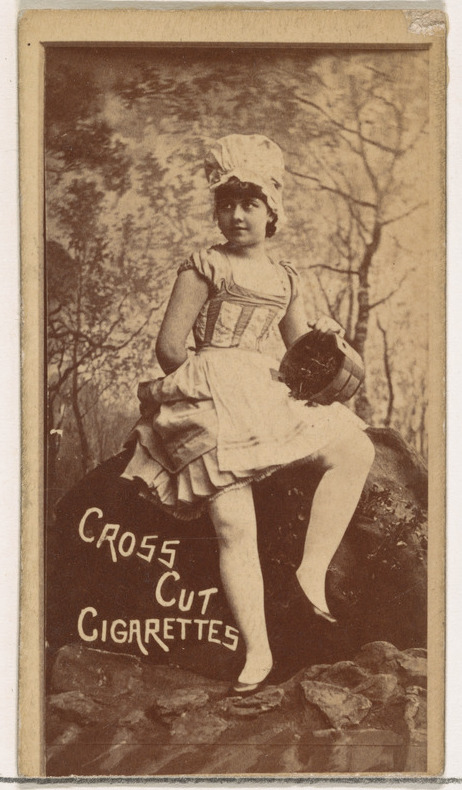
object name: print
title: Actress holding bucket, from the Actors and Actresses series (N145-1) issued by Duke Sons & Co. to promote Cross Cut Cigarettes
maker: w. duke, sons & co.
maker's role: publisher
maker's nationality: american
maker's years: 1870-1920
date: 1880-1889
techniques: albumen silver print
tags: portraits,women,actresses